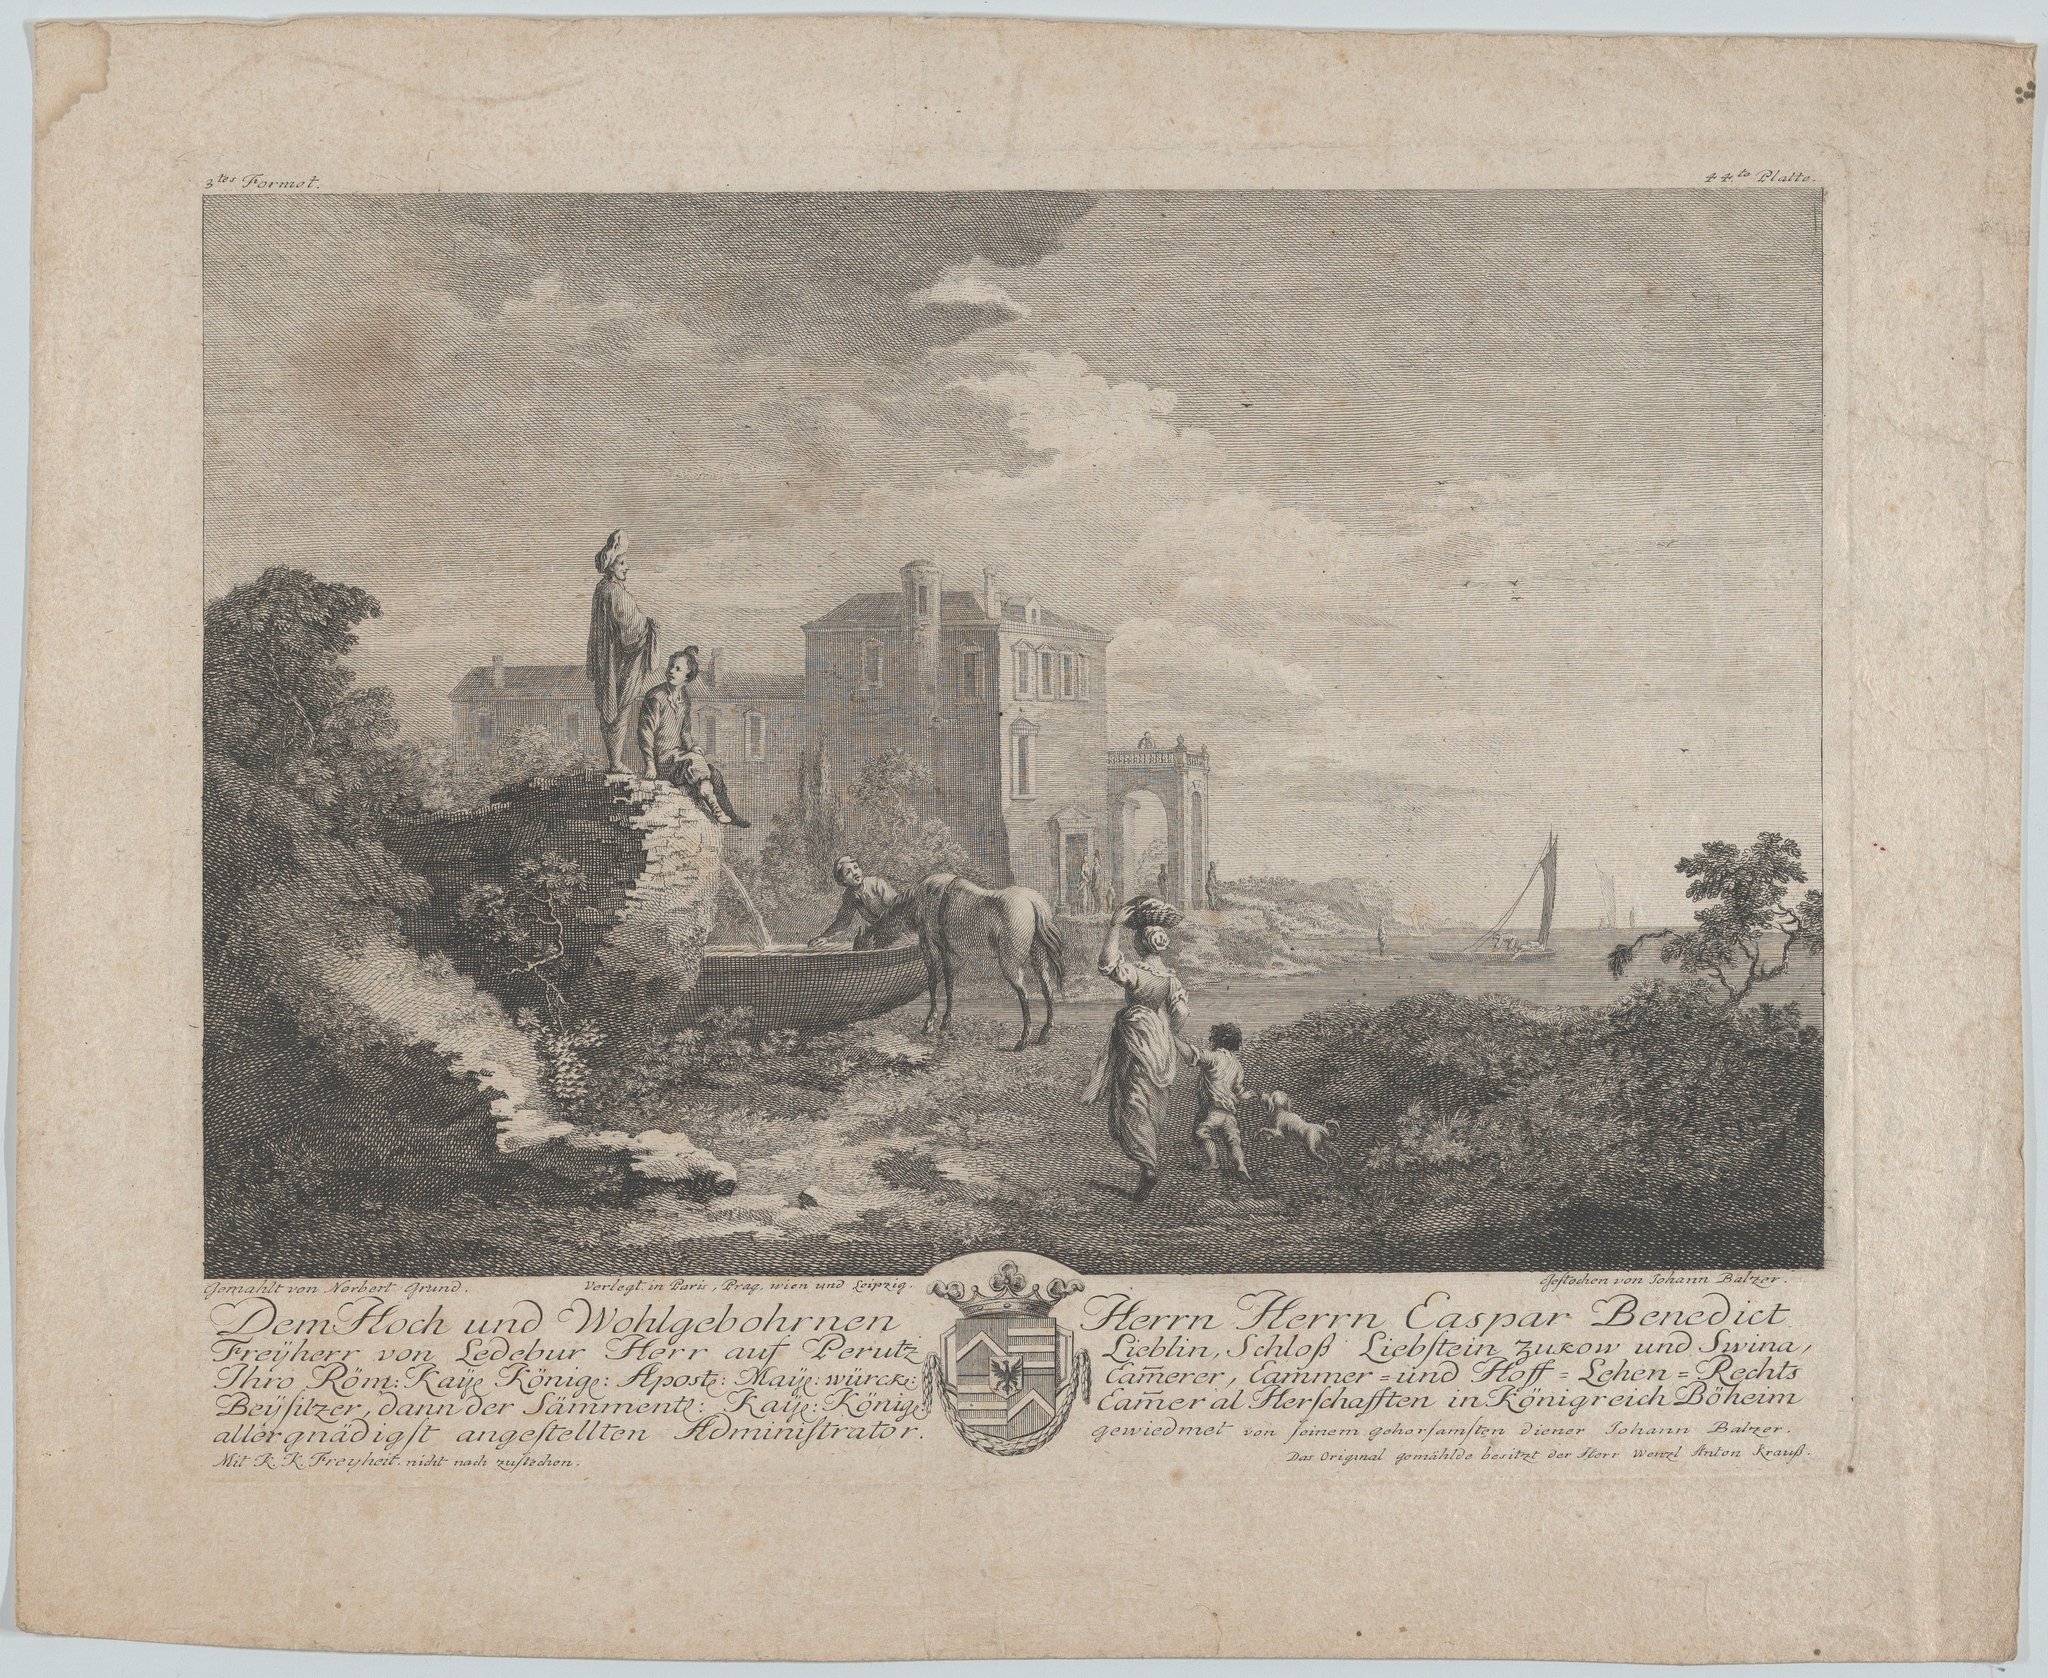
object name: print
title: Landscape with a figures around a fountain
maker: johann balzer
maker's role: artist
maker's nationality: czech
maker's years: 1738-1799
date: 1760-1799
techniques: engraving